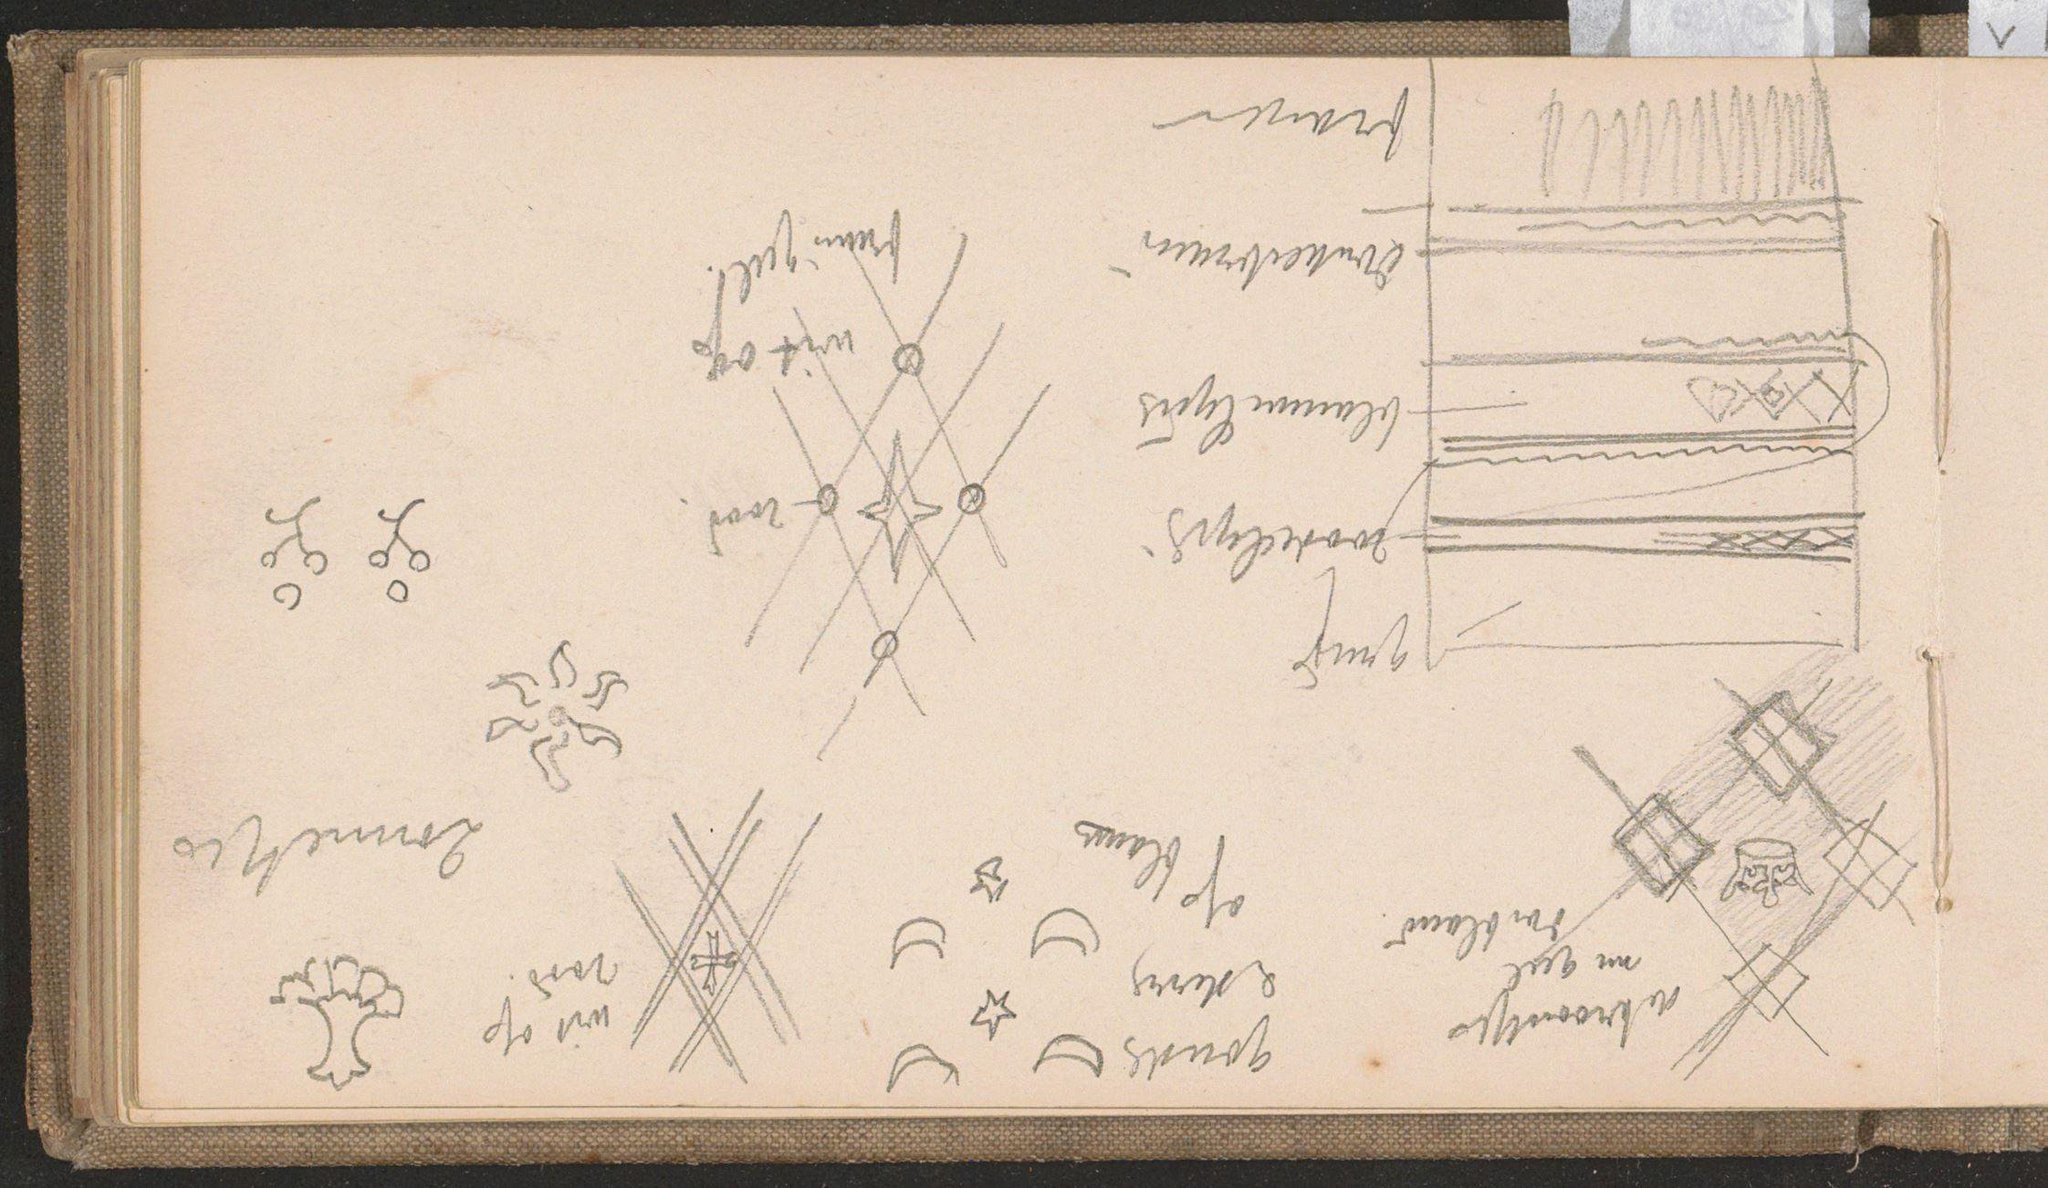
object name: sketchbook leaf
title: Decoratieve patronen, onder andere met kronen, zonnen en sterren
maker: antoon derkinderen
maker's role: draughtsman, painter, print maker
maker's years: 1859-1925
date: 1892-1901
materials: paper, pencil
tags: ornaments ~ art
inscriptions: kleurnotitie, handgeschreven in potlood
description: Blad 30 verso uit een schetsboek met 51 bladen.